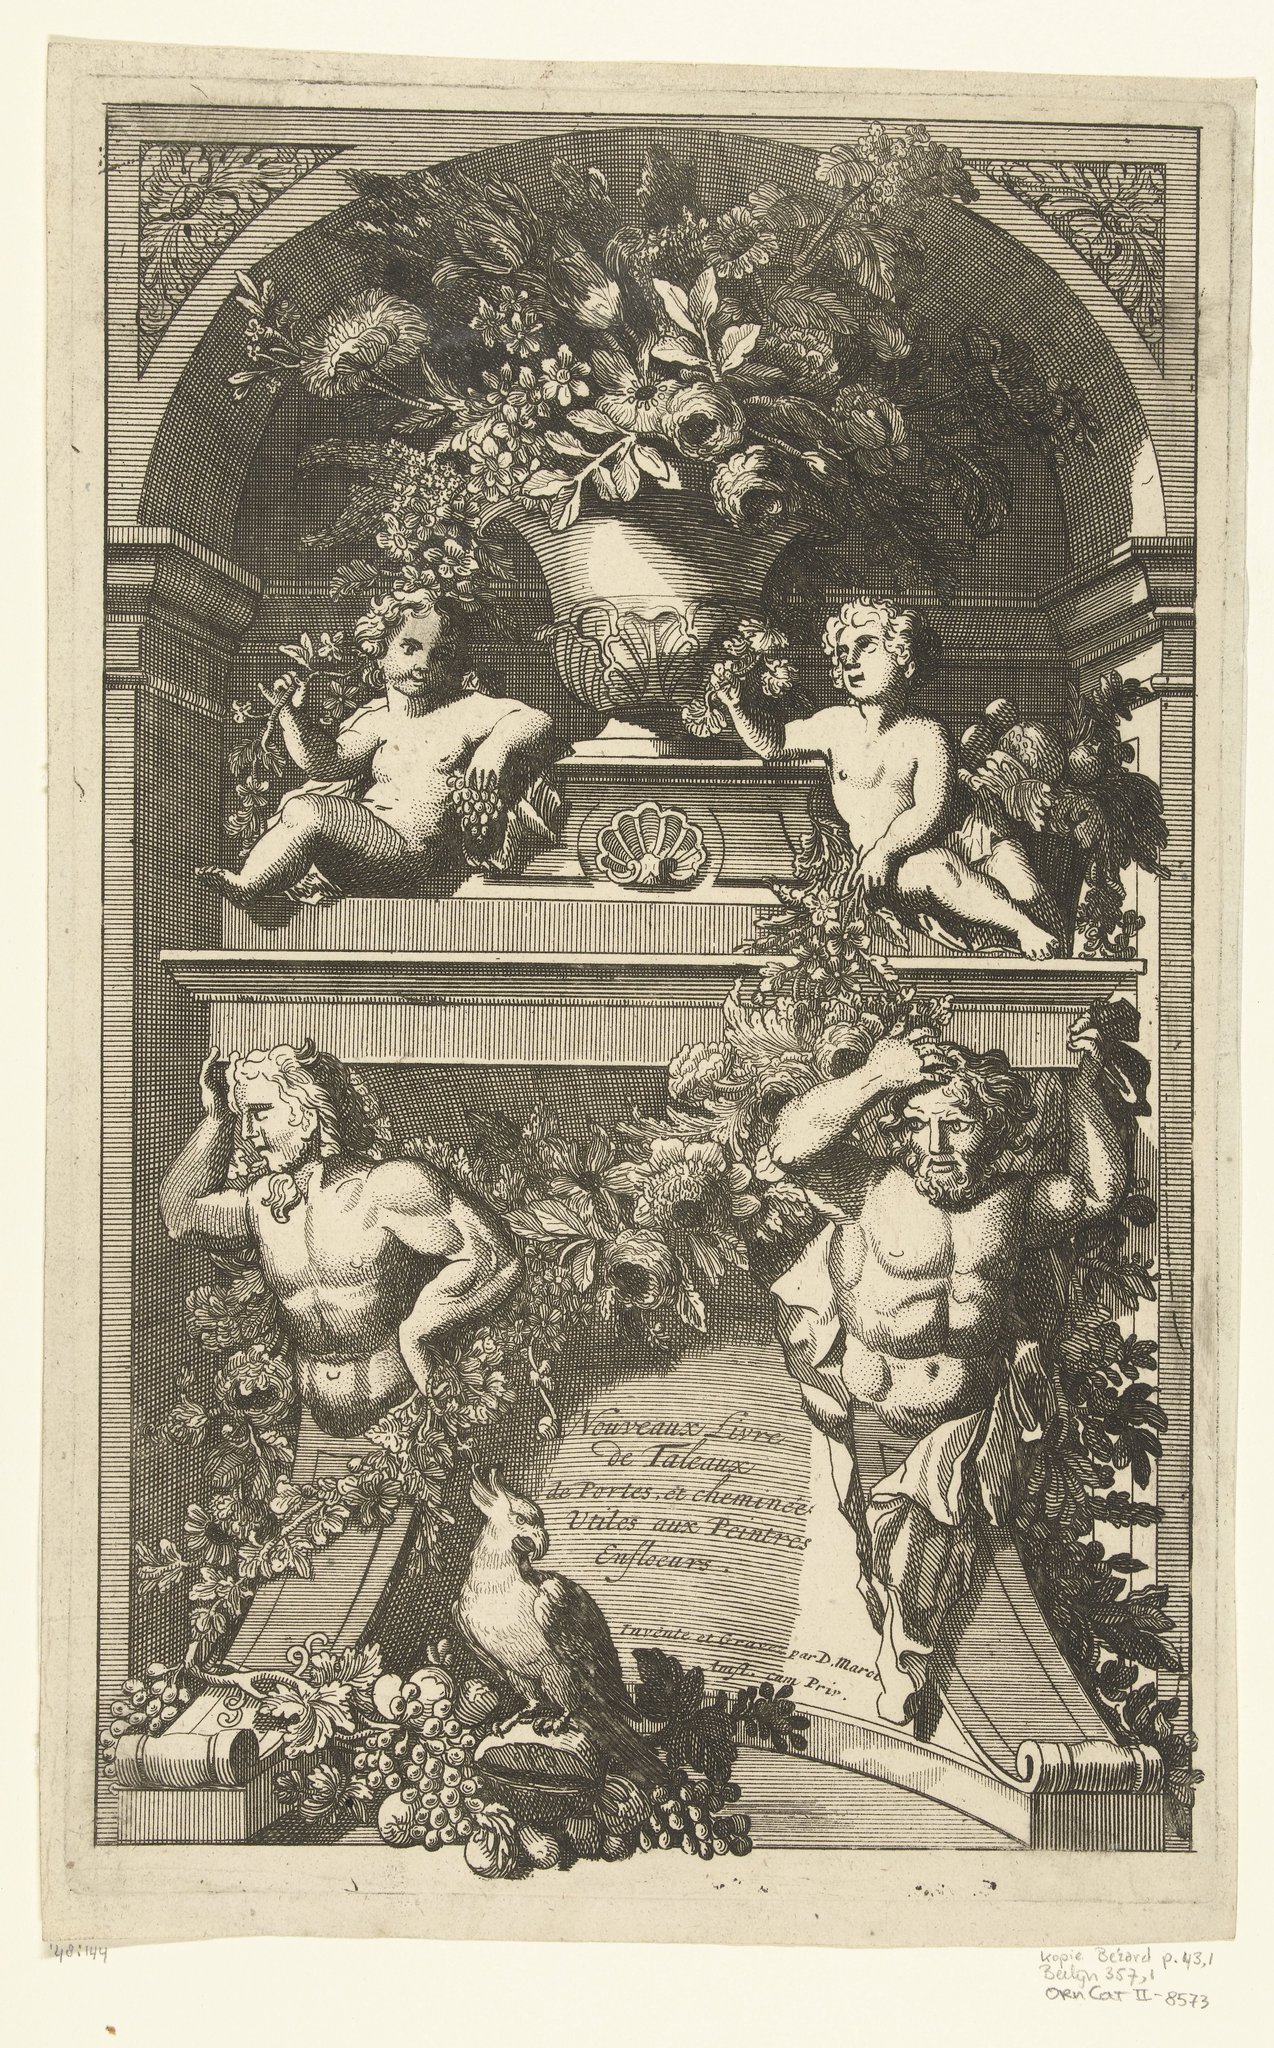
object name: print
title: Nouveaux Livre de Taleaux de Portes, et cheminée Utiles aux Peintres Enfloeurs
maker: daniël marot (i)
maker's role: draughtsman, print maker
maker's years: 1661-1752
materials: paper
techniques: etching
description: In een nis staat een voetstuk gesteund door twee termen met daarop een vaas met bloemen en aan weerszijden een putto. Kopie naar blad uit de serie Nouveaux Liure de Tableaux de Portes uitgegeven door Daniel Marot tussen 1703 en 1712.